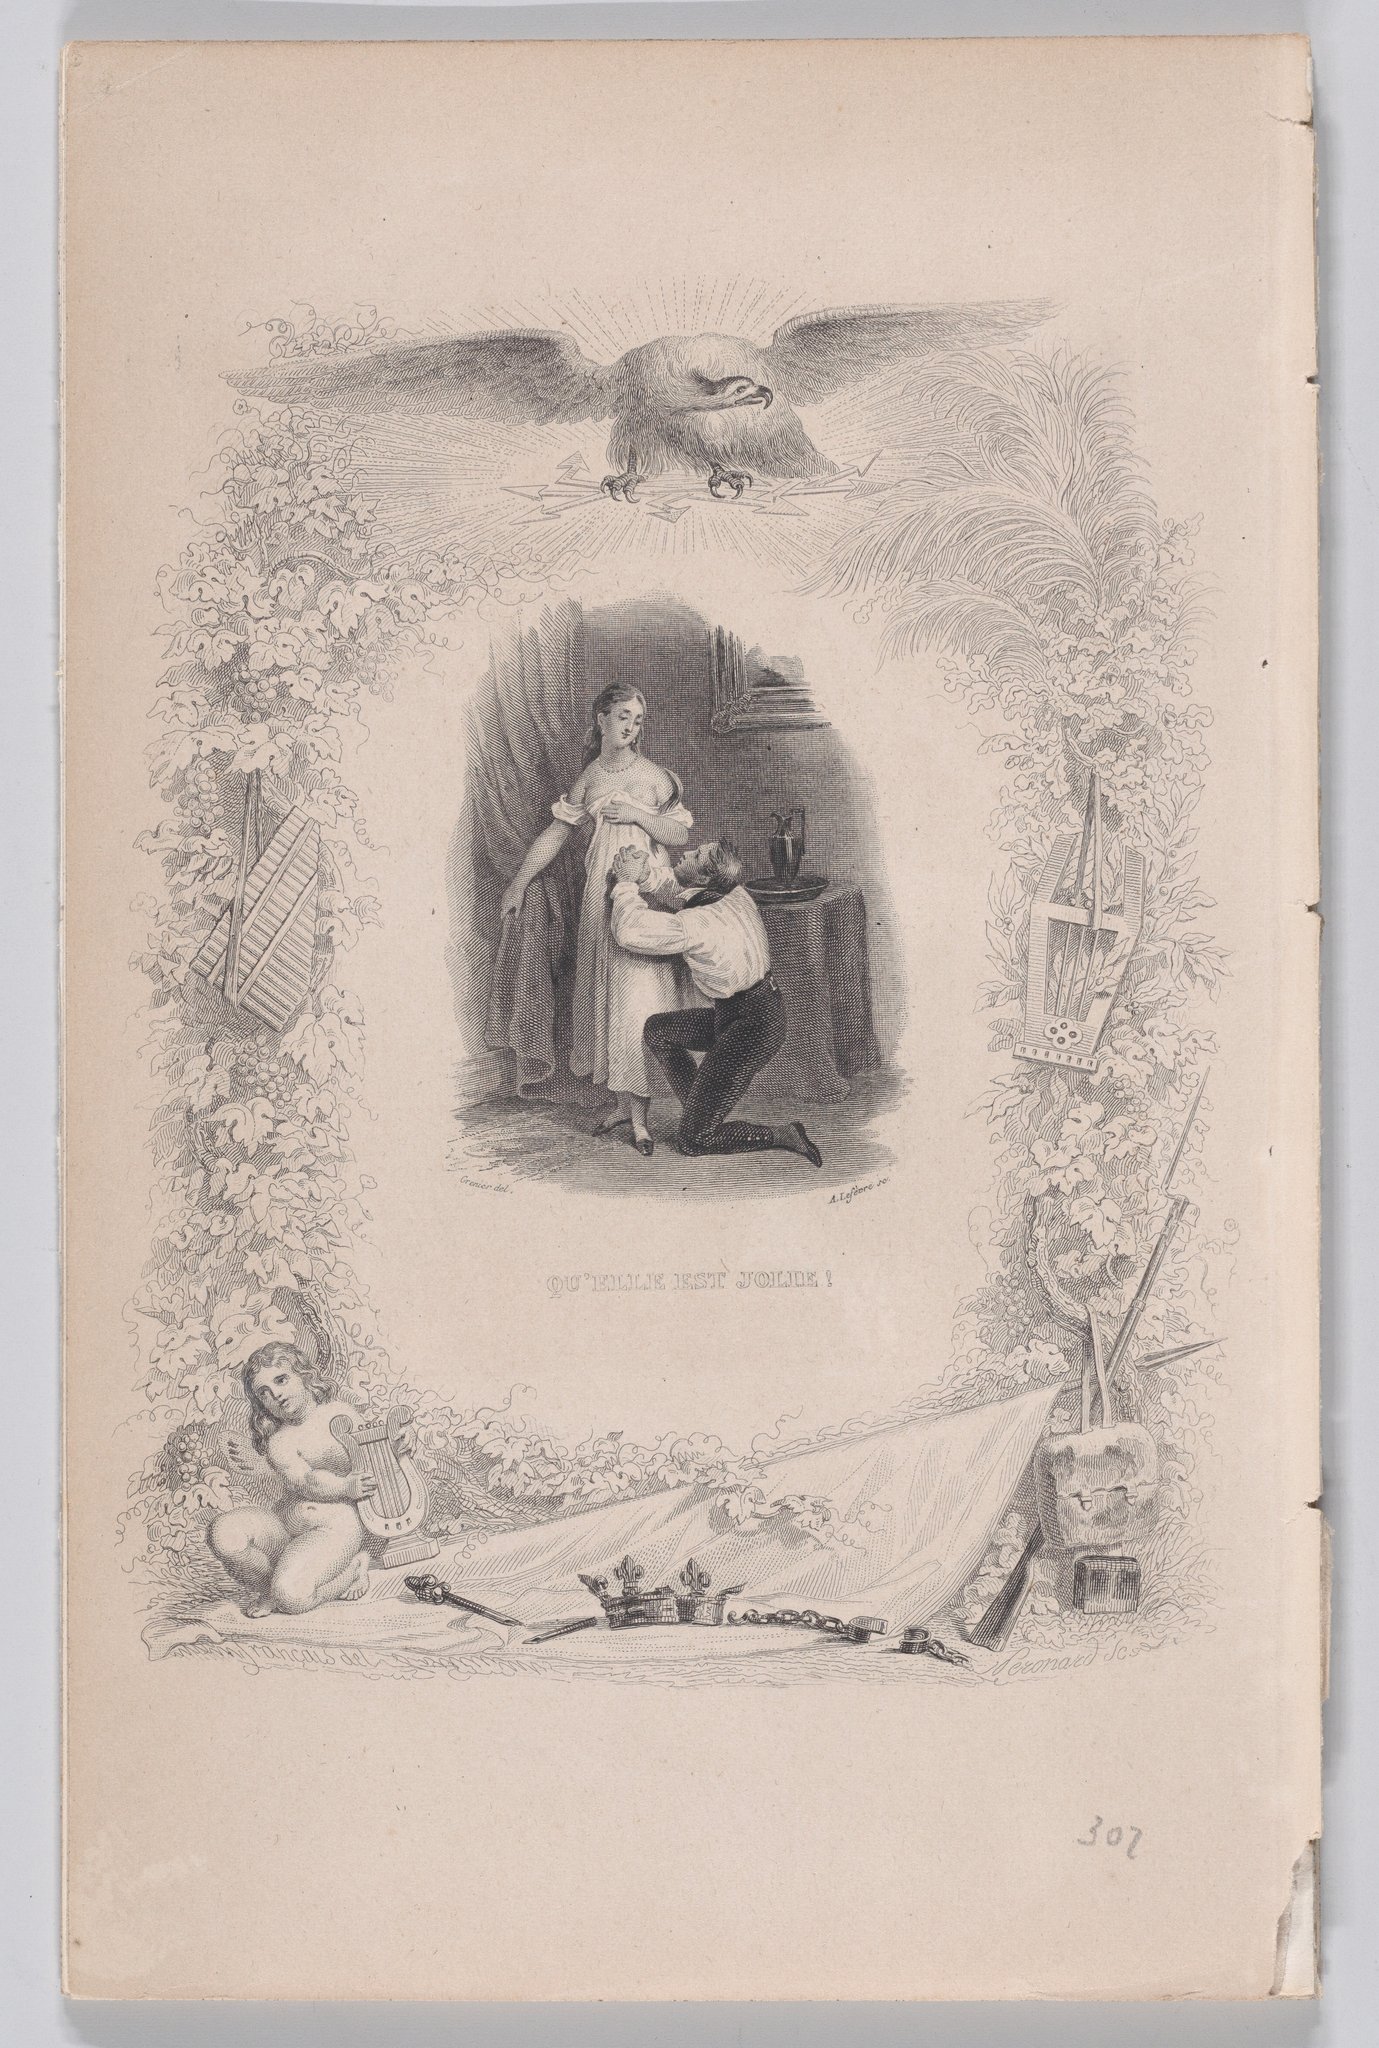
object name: print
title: She is Beautiful!, from "The Complete Works of Béranger"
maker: françois grenier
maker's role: designer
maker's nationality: french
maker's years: 1793-1867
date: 1829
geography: paris